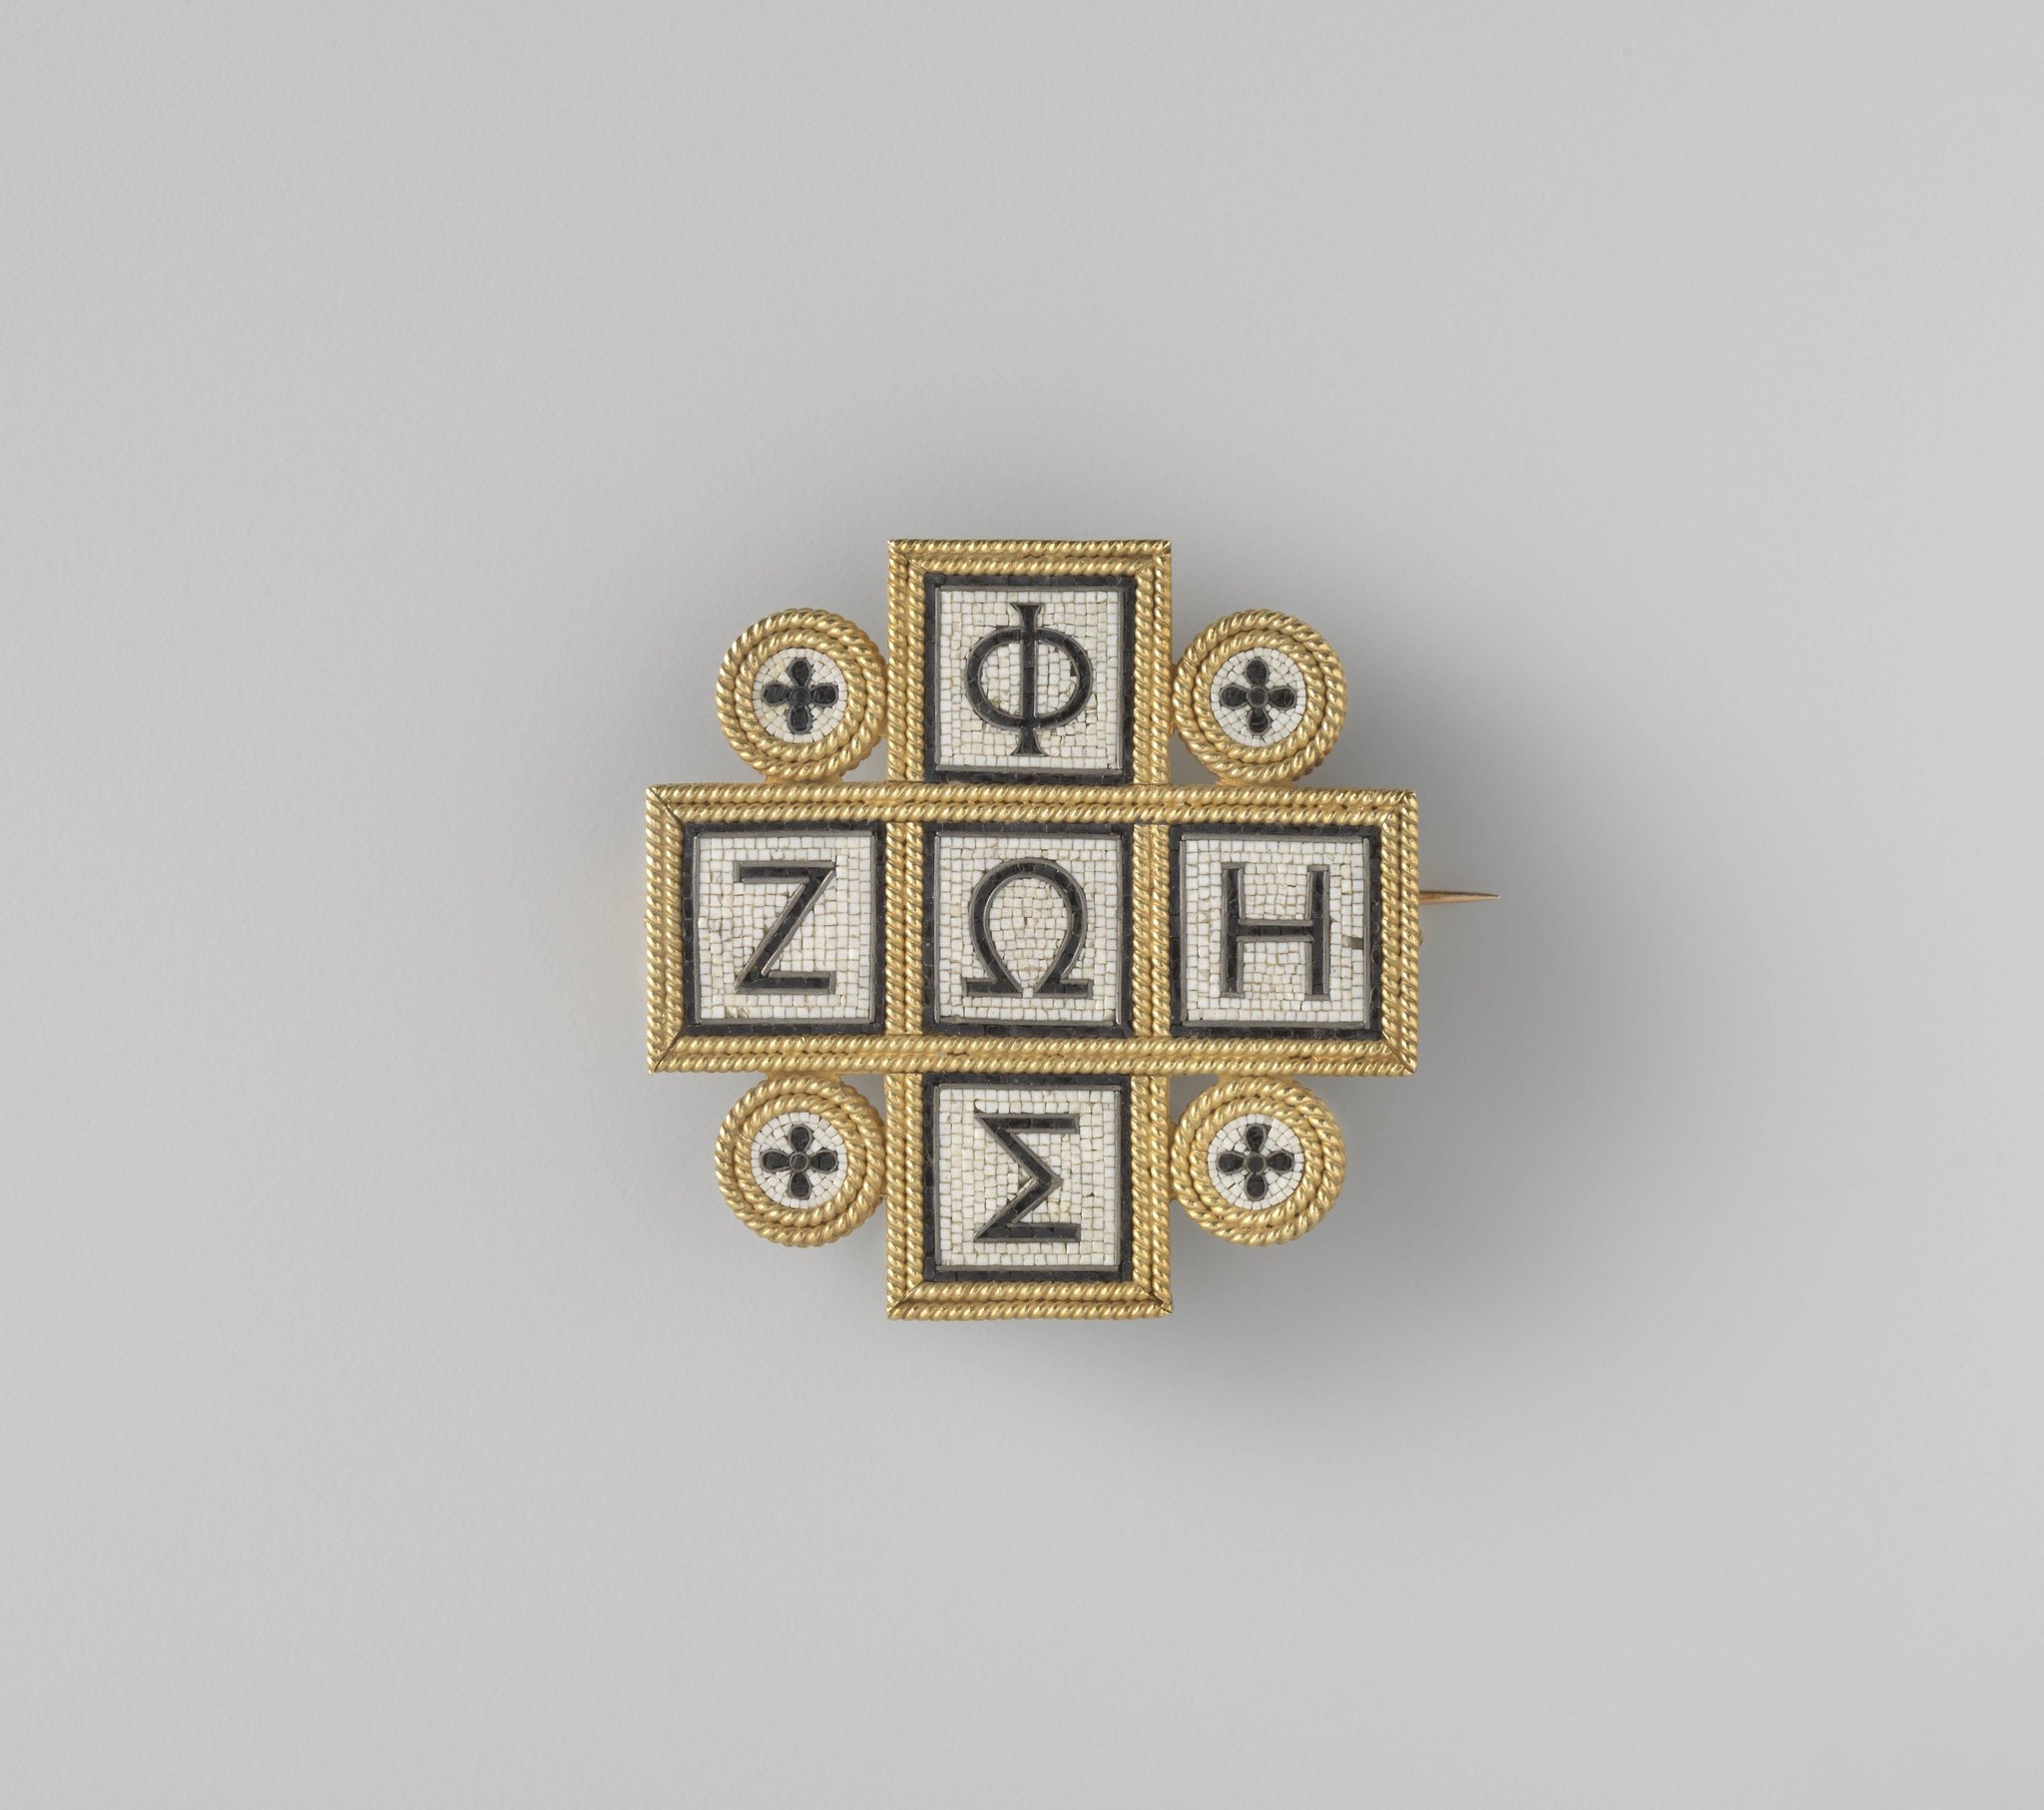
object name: jewellery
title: Broche in de vorm van Grieks Kruis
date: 1860-1875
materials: glass, gold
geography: rome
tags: specific forms of the cross: greek cross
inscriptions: monogram: ‘CC in monogram’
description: Brooch. Gold and glass. Rome, c. 1860 - 1875, by Alessandro and Augusto Castellani. Given by Jonkvrouwe C.I. Six, 1978.